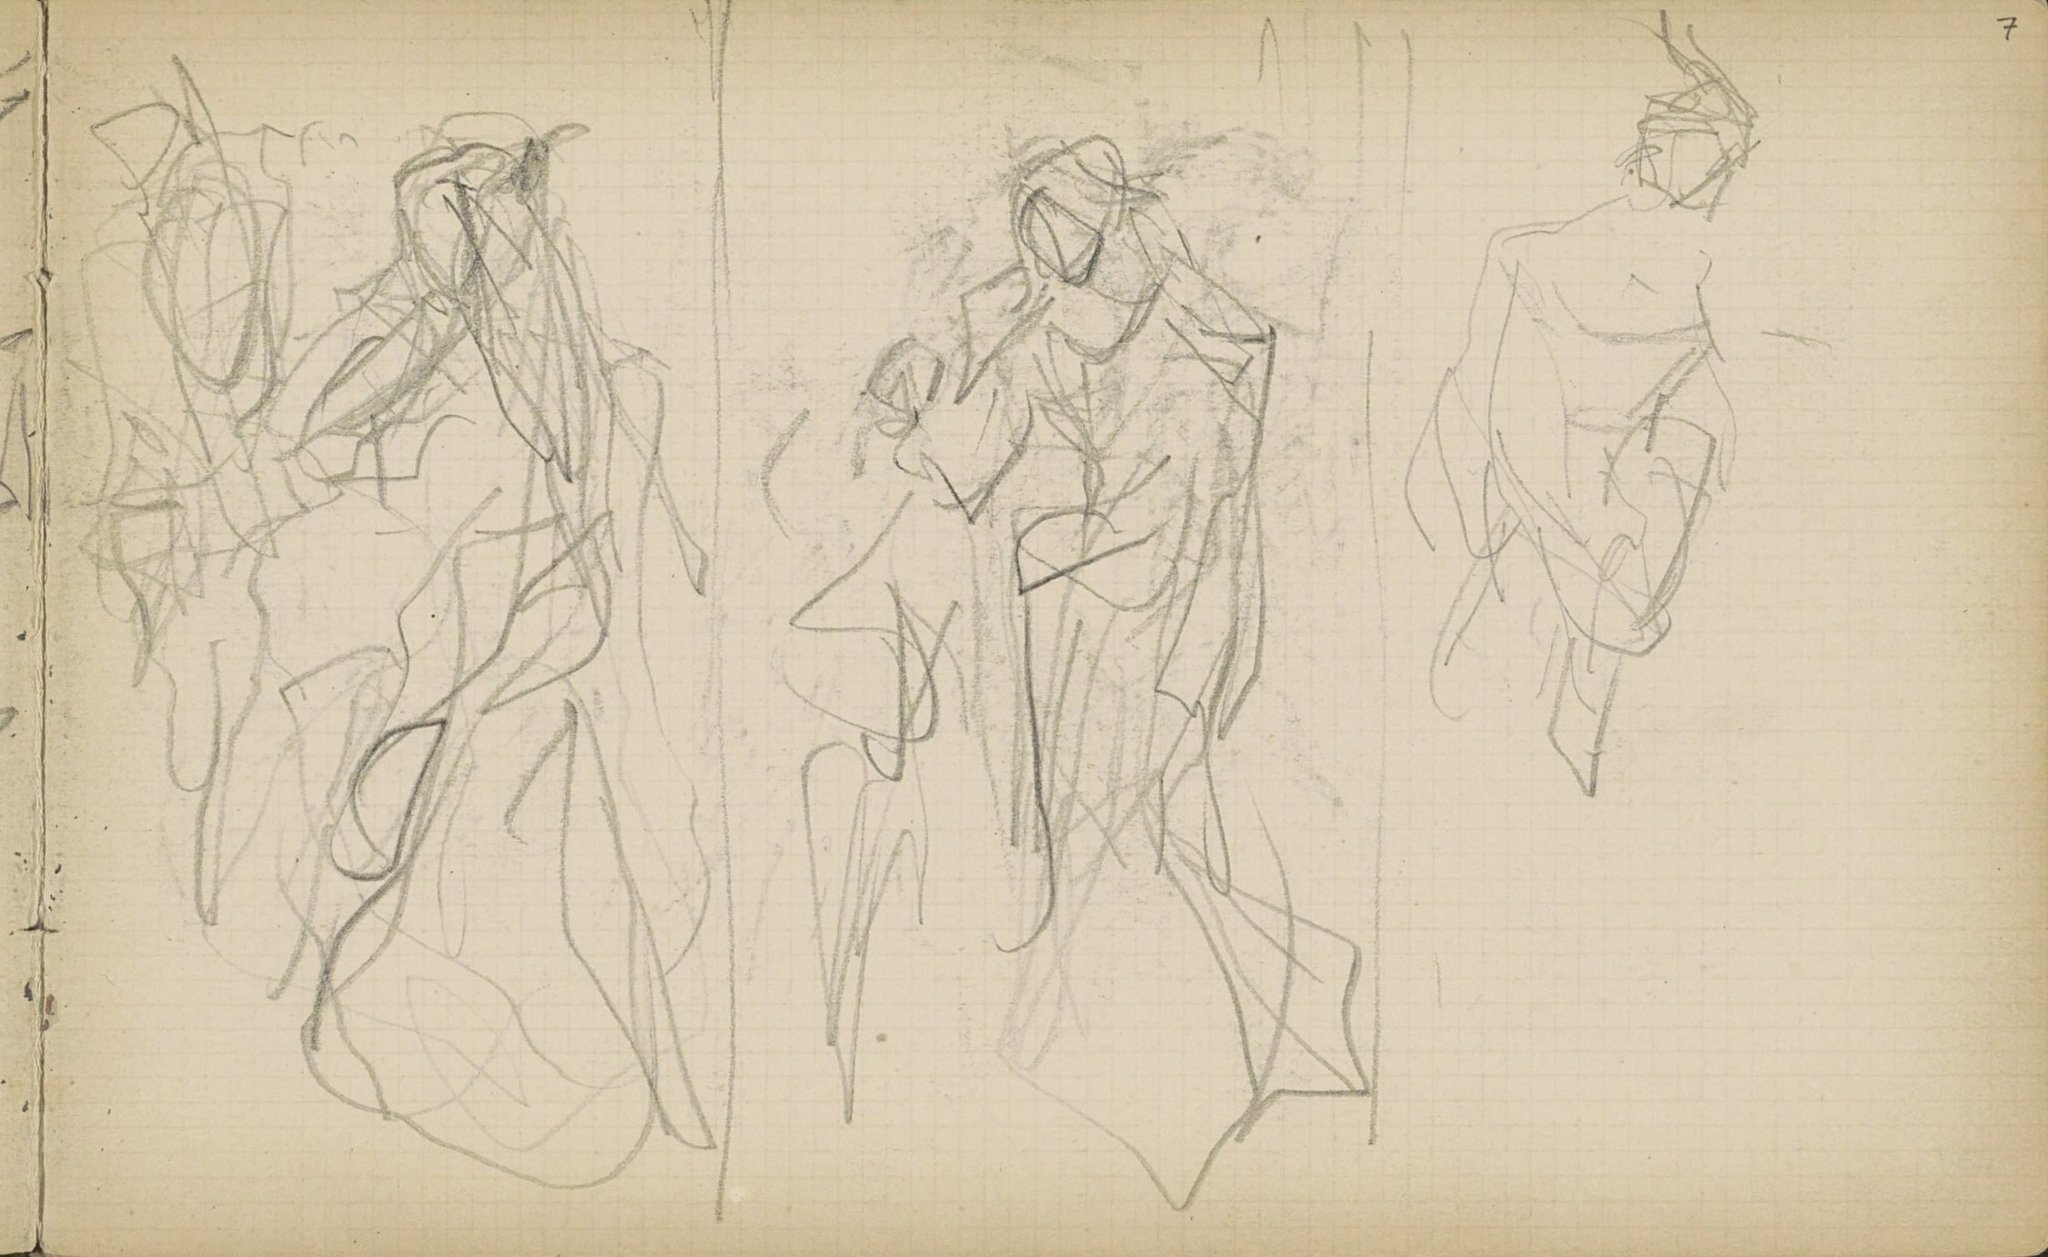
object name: sketchbook leaf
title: Figuurstudies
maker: matthijs maris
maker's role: draughtsman, painter, print maker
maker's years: 1839-1917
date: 1849-1917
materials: pencil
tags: anatomy (non-medical)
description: Blad 7 recto uit een schetsboek met 35 bladen.